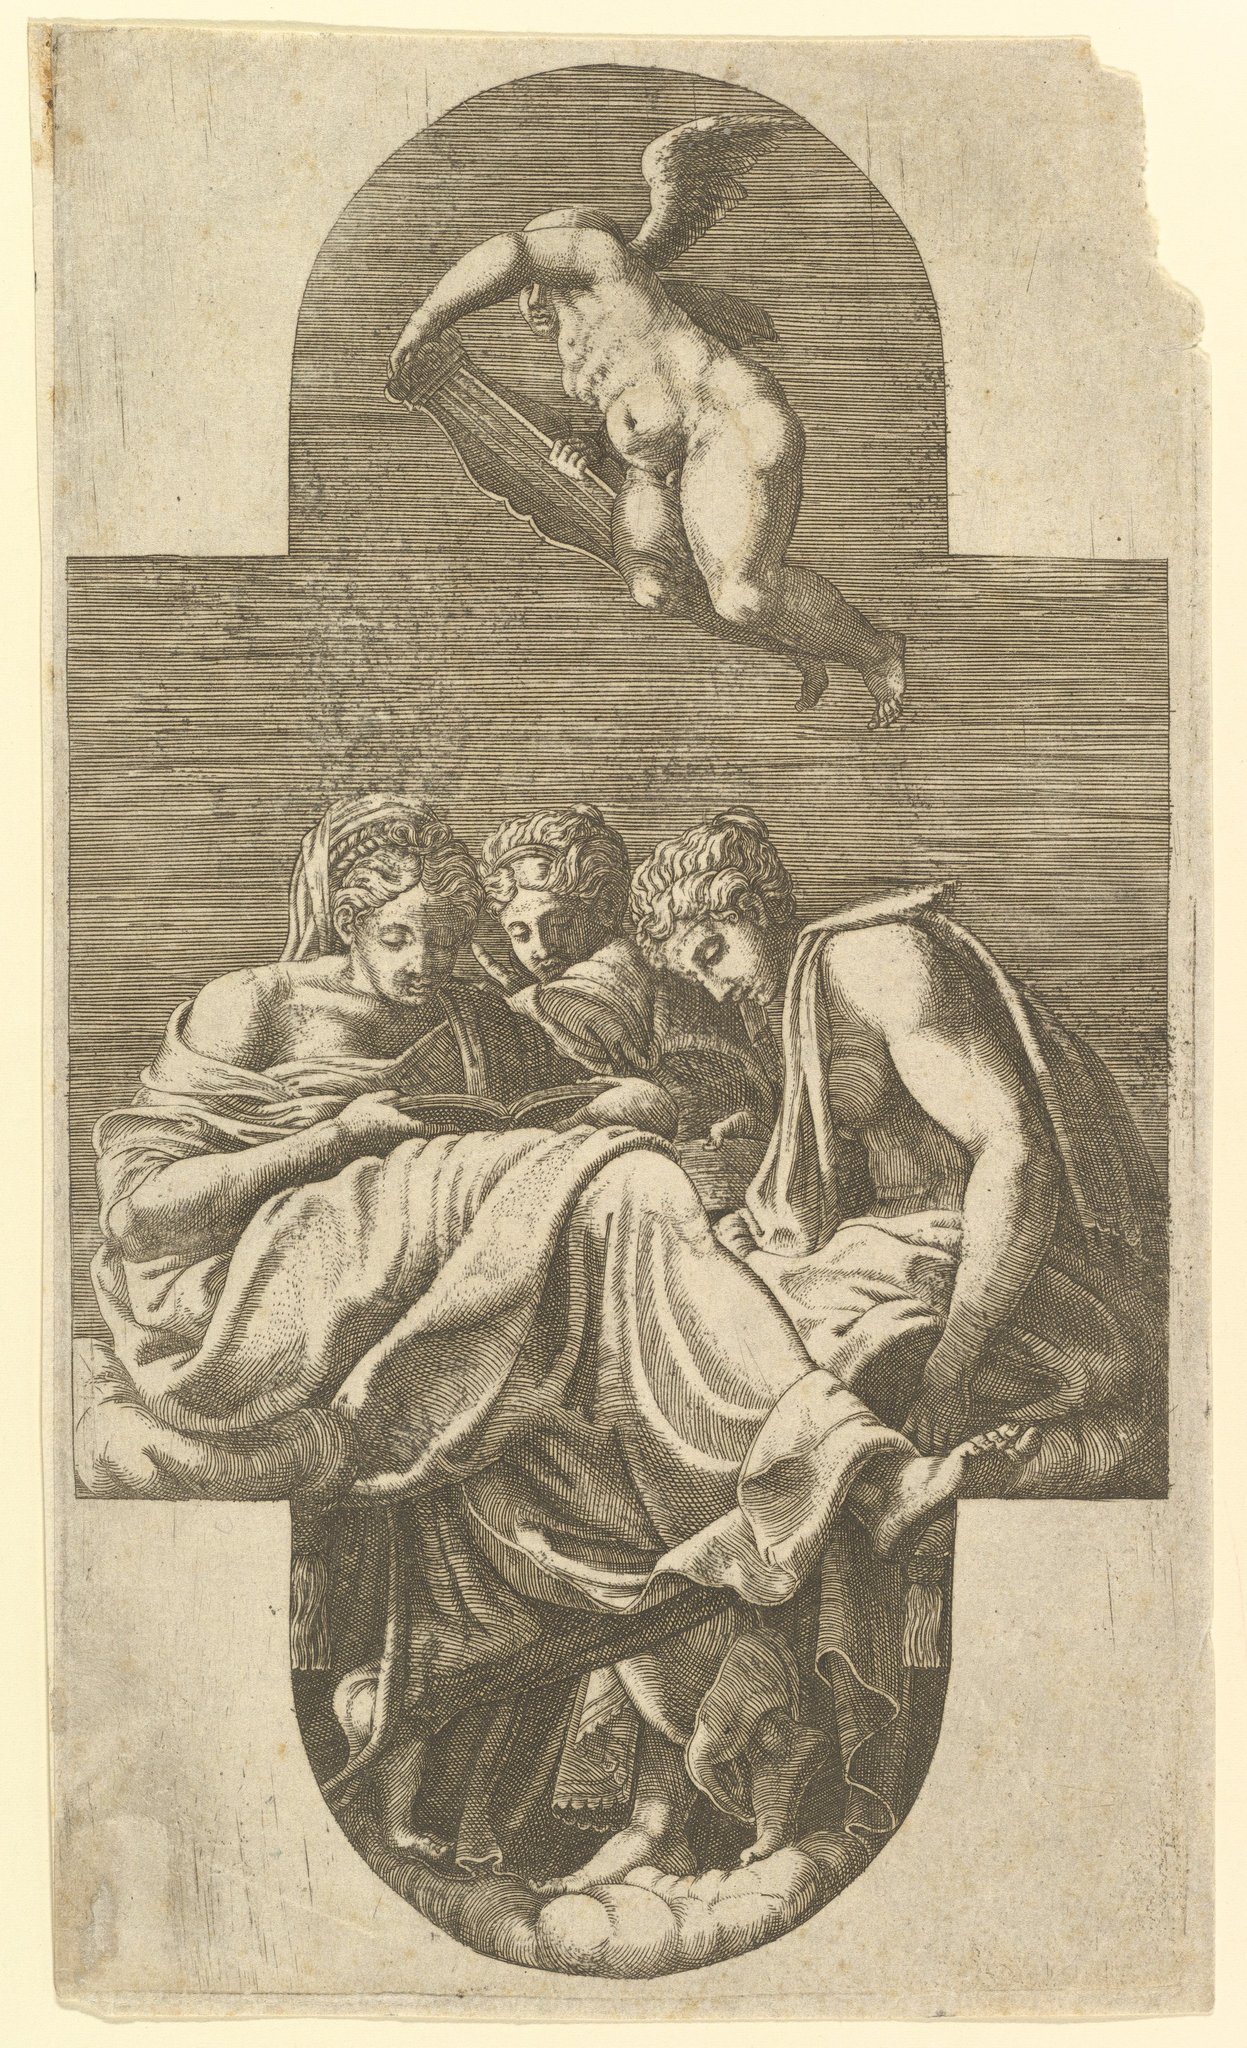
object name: print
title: Three Muses and a Putto with a Lyre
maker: giorgio ghisi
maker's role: artist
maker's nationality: italian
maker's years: 1515-1582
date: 1560-1569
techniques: engraving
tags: musical instruments,muses